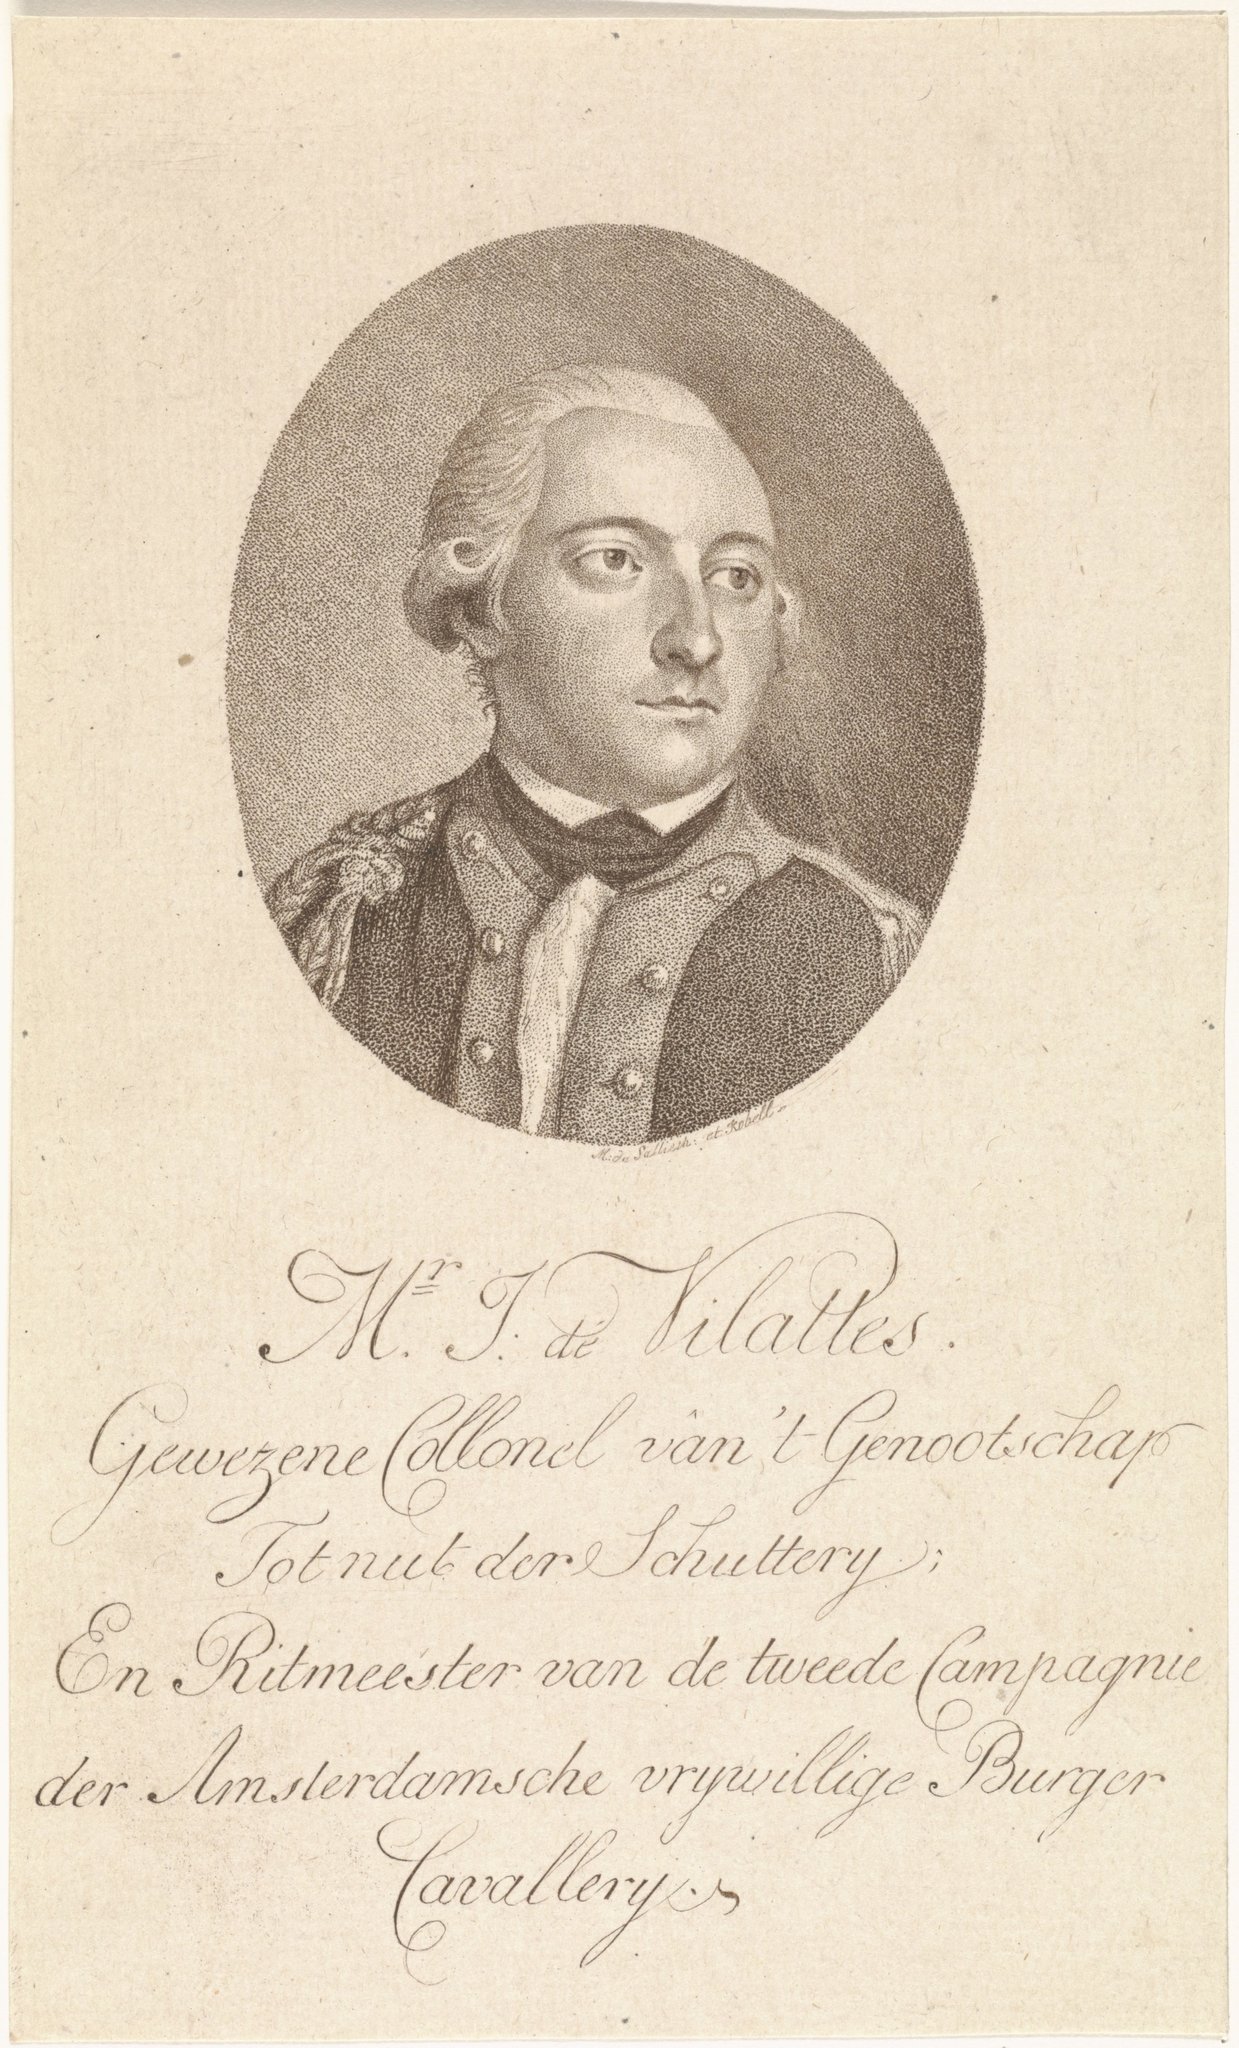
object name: print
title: Portret van Jean Henri des Villates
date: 1764-1791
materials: paper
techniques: etching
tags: advocaat, schrijver, ritmeester, jean henri des villates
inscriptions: collector's mark: Lugt 2228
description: Portret van Jean Henri des Villates, advocaat, ritmeester en schrijver.